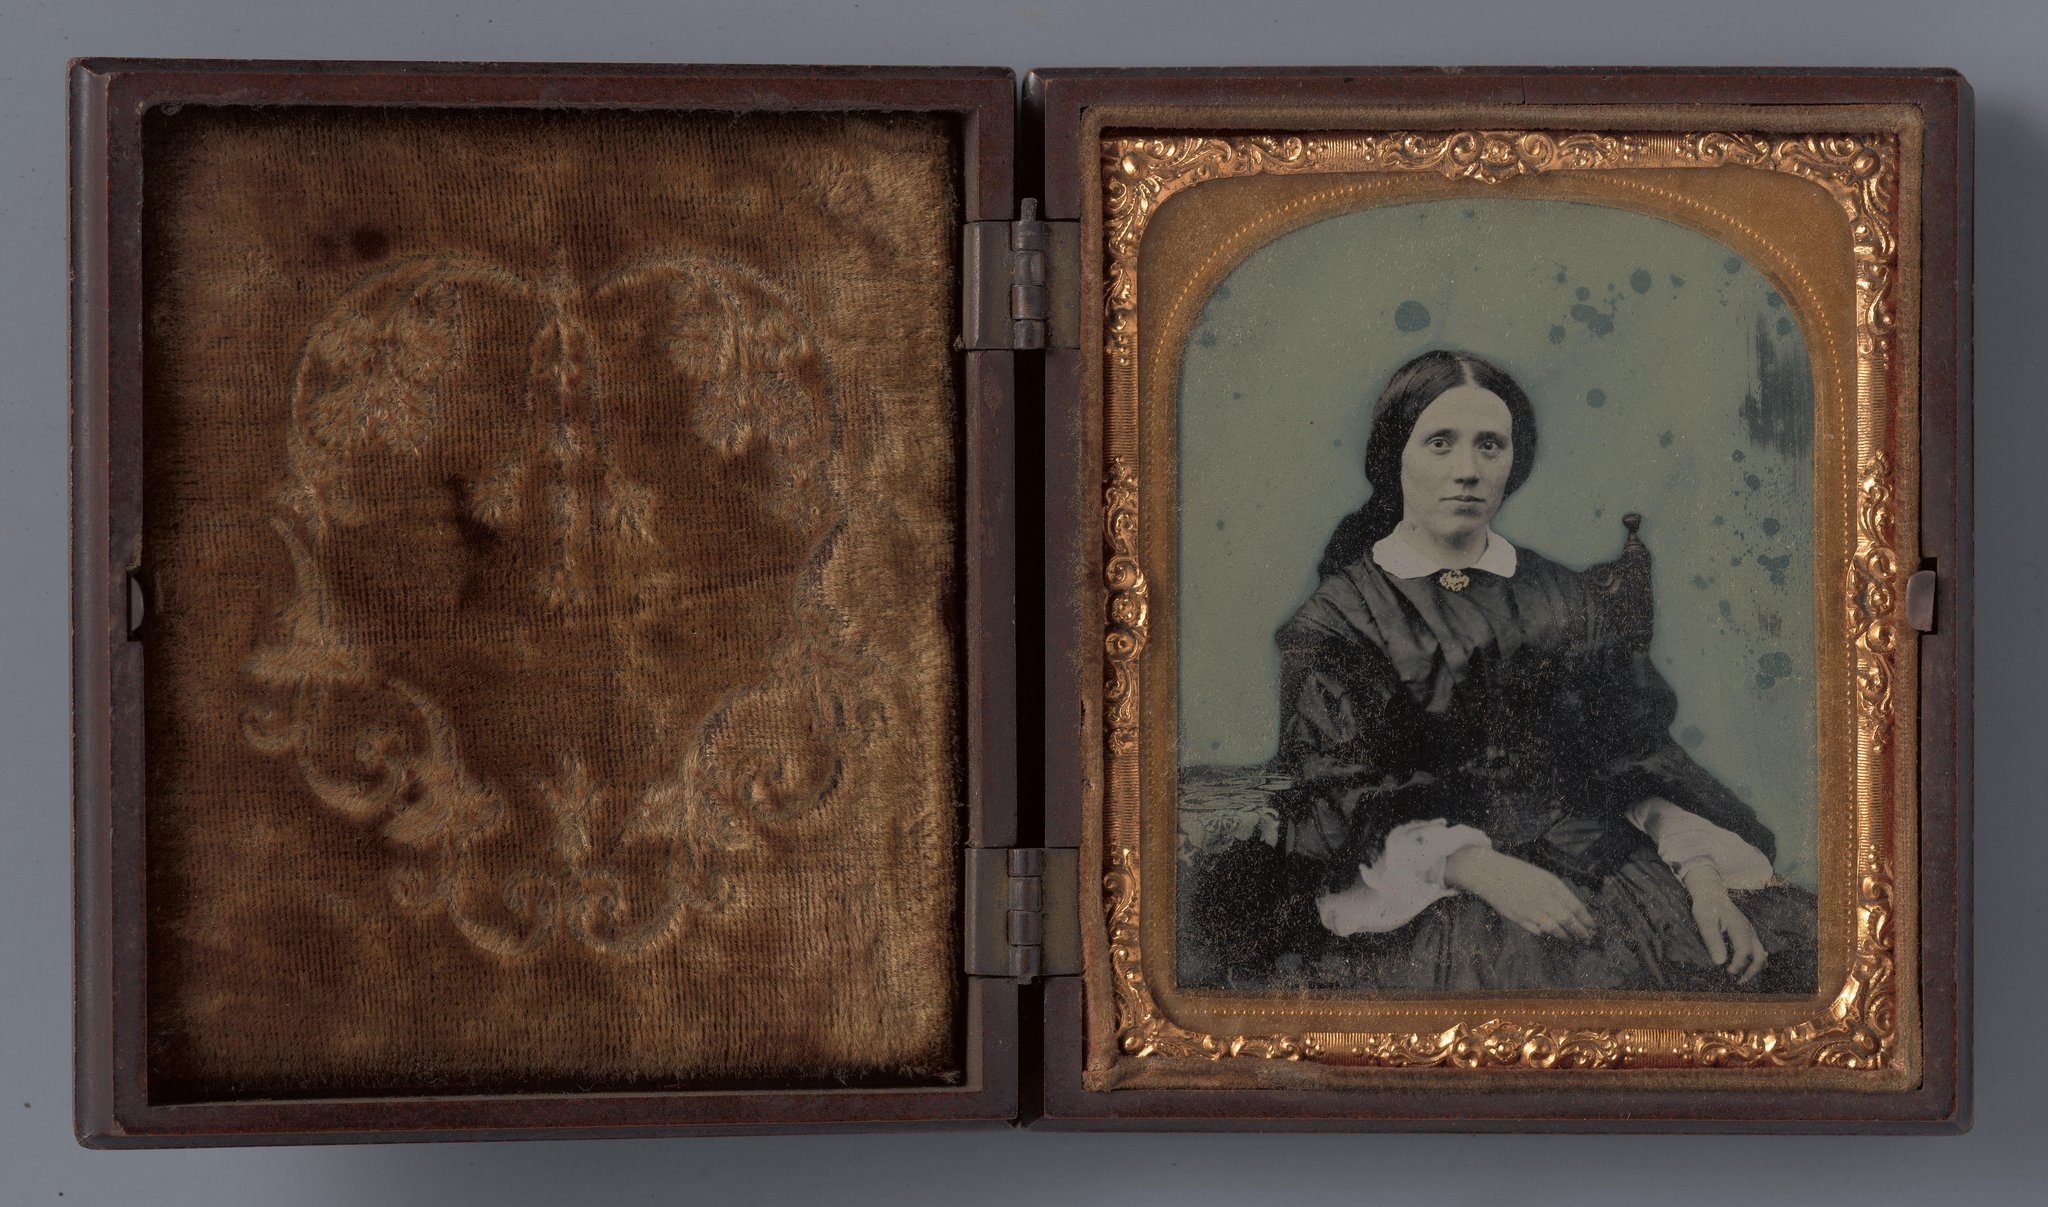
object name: photograph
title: Portret van een onbekende vrouw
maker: Anonymous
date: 1855-1870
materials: glass, metal, plastic, velvet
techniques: ambrotype, hand coloring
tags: adult woman, sitting figure - aa - female human figure, historical persons